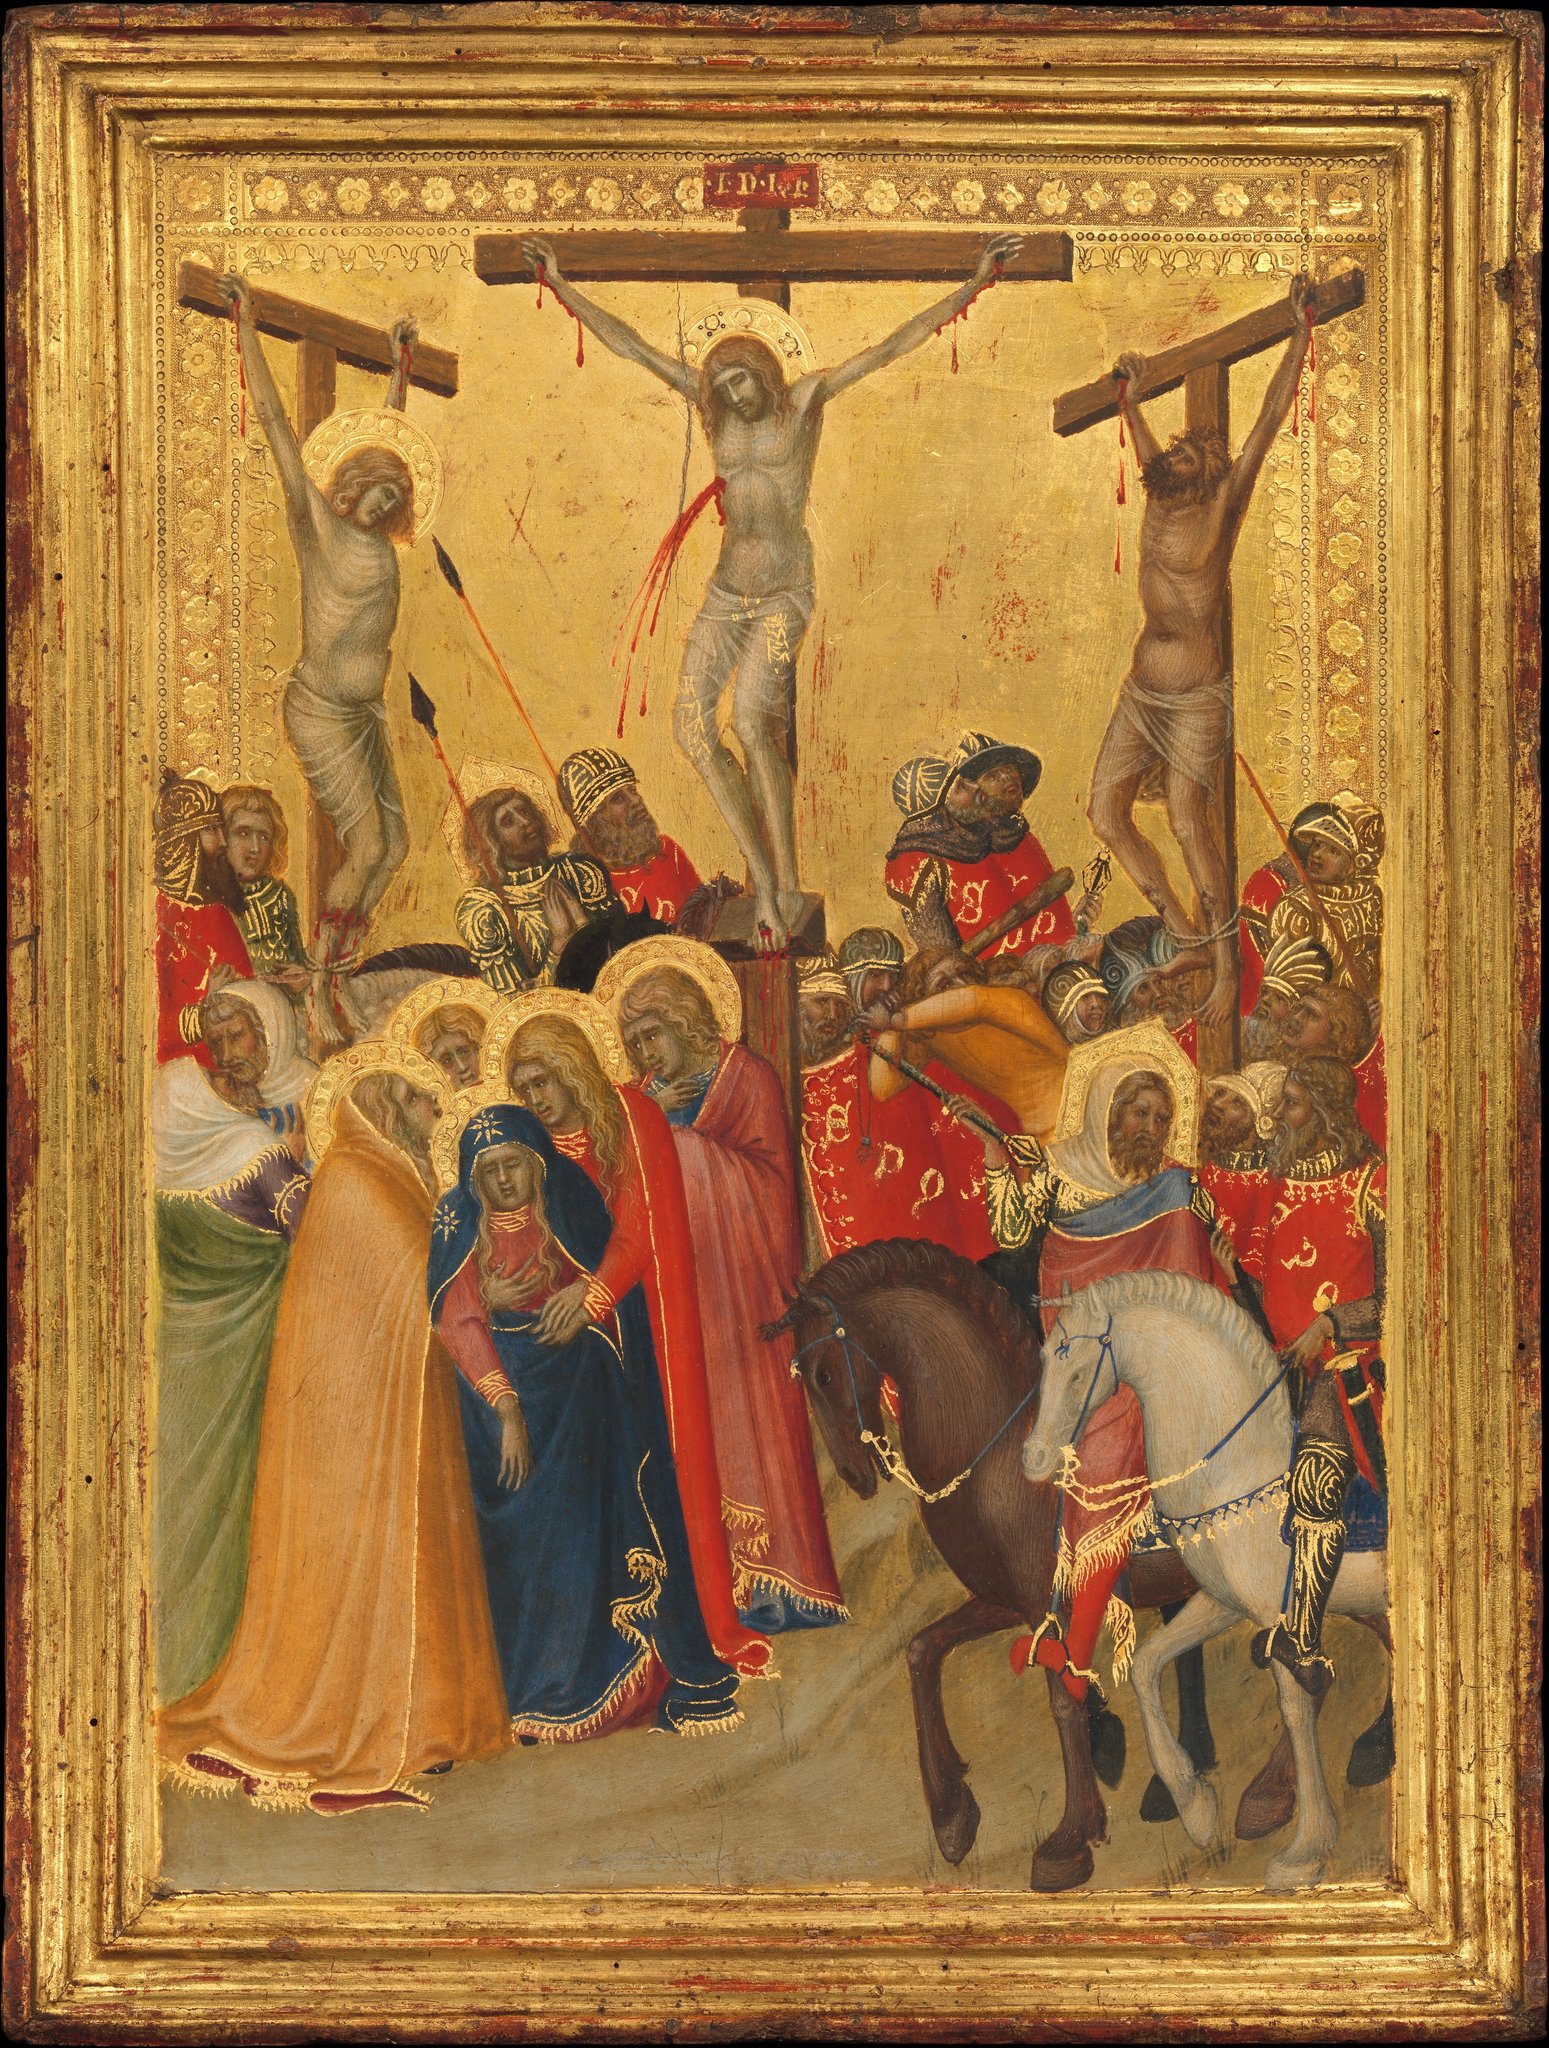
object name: painting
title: The Crucifixion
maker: pietro lorenzetti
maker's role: artist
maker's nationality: italian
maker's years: 1320-1344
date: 1340-1349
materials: gold leaf, paint, wood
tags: men,women,horses,christ,virgin mary,crucifixion